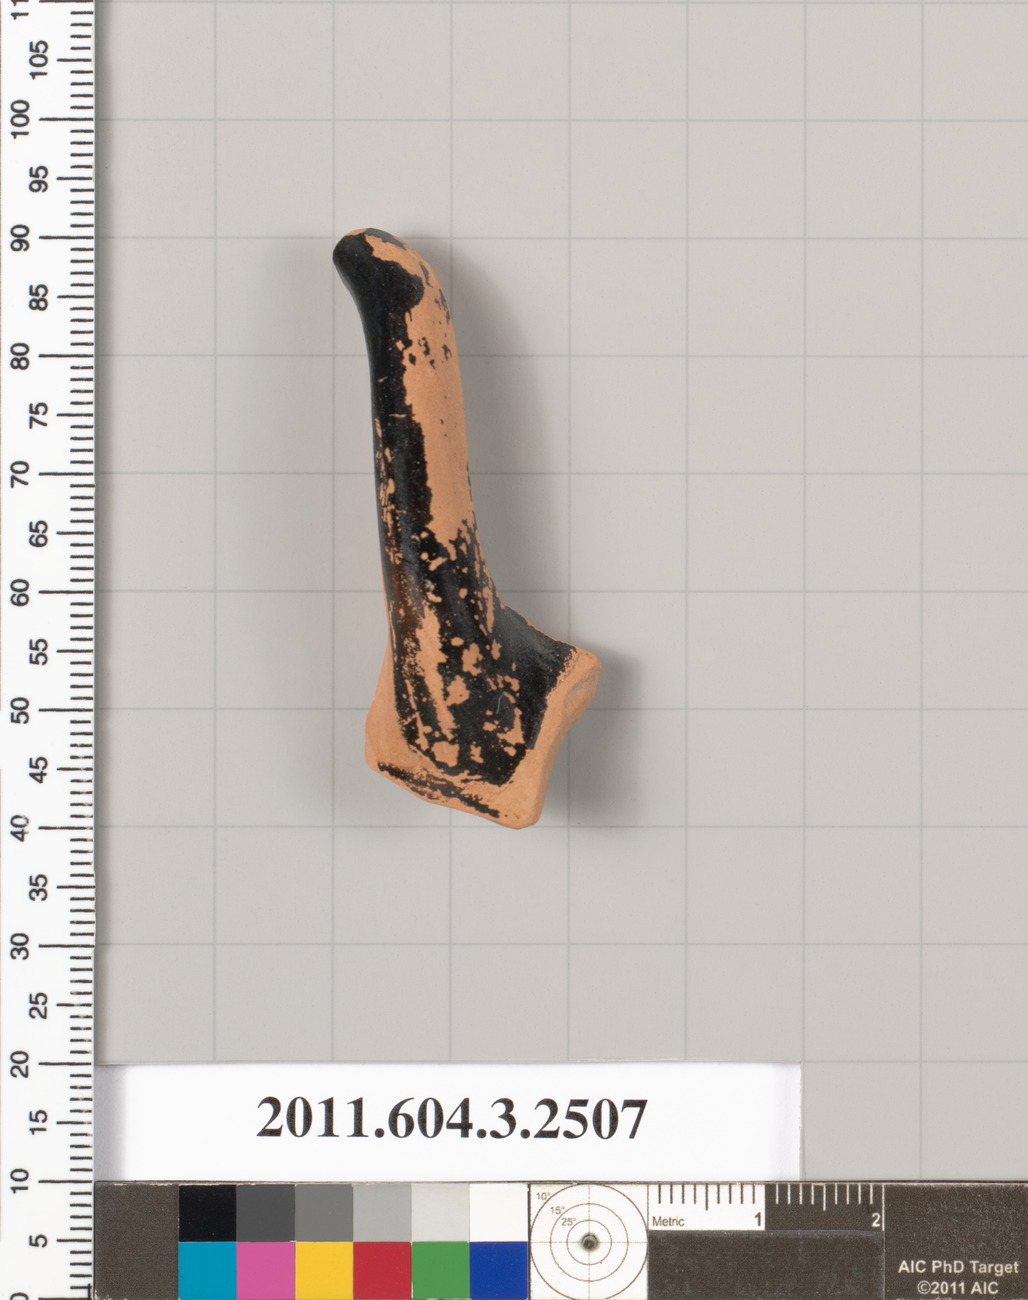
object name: kylix fragment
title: Terracotta fragment of a kylix (drinking cup)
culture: greek, attic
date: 600-401 BCE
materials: terracotta